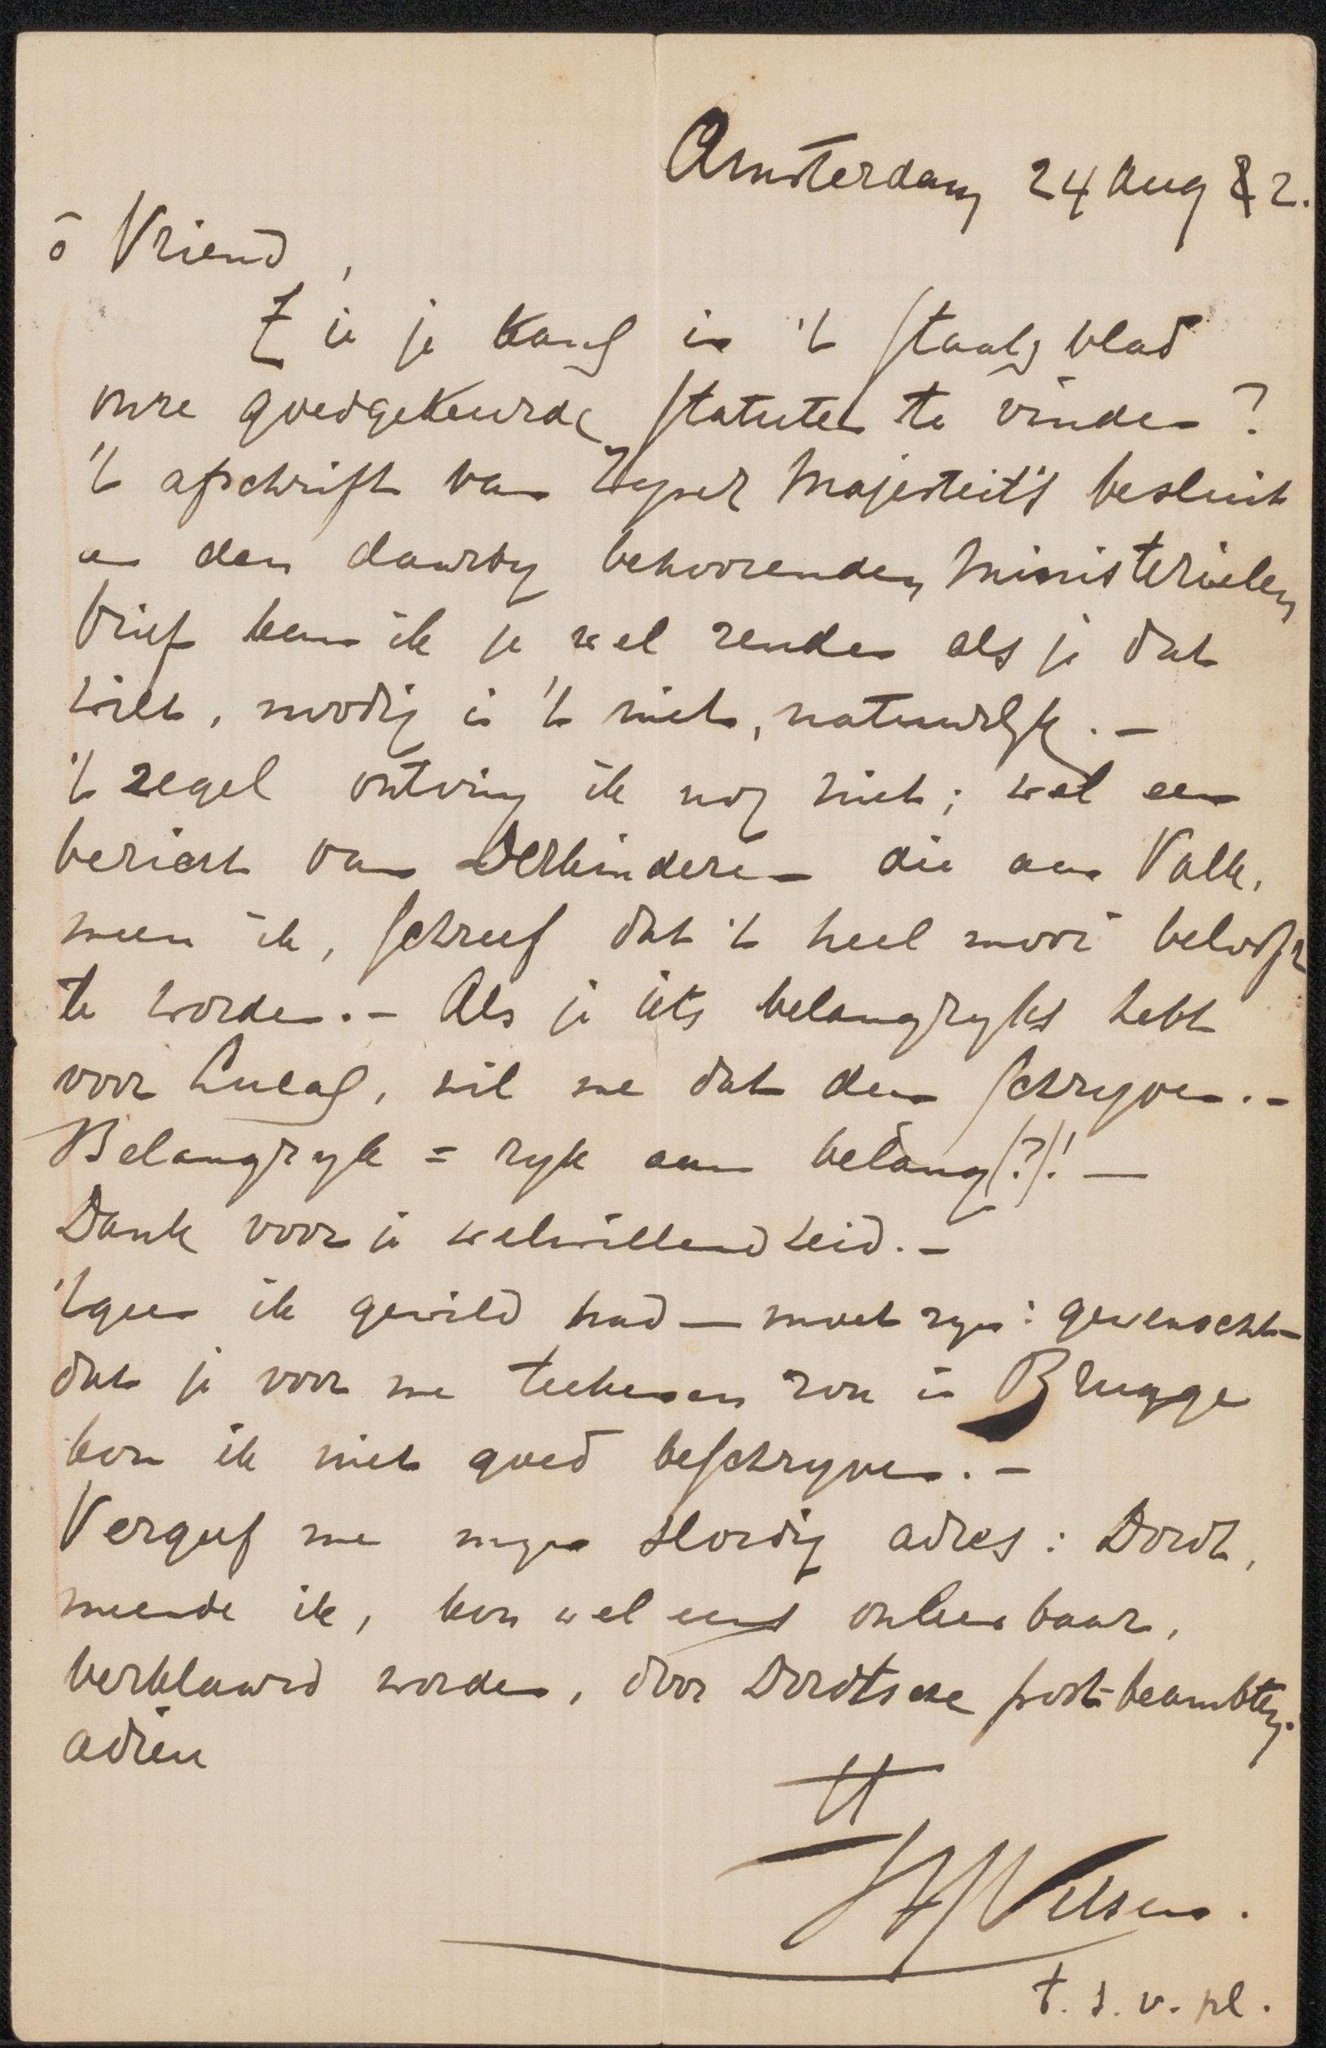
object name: letter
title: Brief aan Jan Veth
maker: willem witsen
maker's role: draughtsman, painter, print maker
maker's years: 1860-1923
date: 1882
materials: ink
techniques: pen, writing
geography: amsterdam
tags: dordrecht, amsterdam, painter, print maker, draughtsman, designer, jan veth, maurits van der valk, den bosch, antoon derkinderen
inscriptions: collector's mark: ‘RPK’